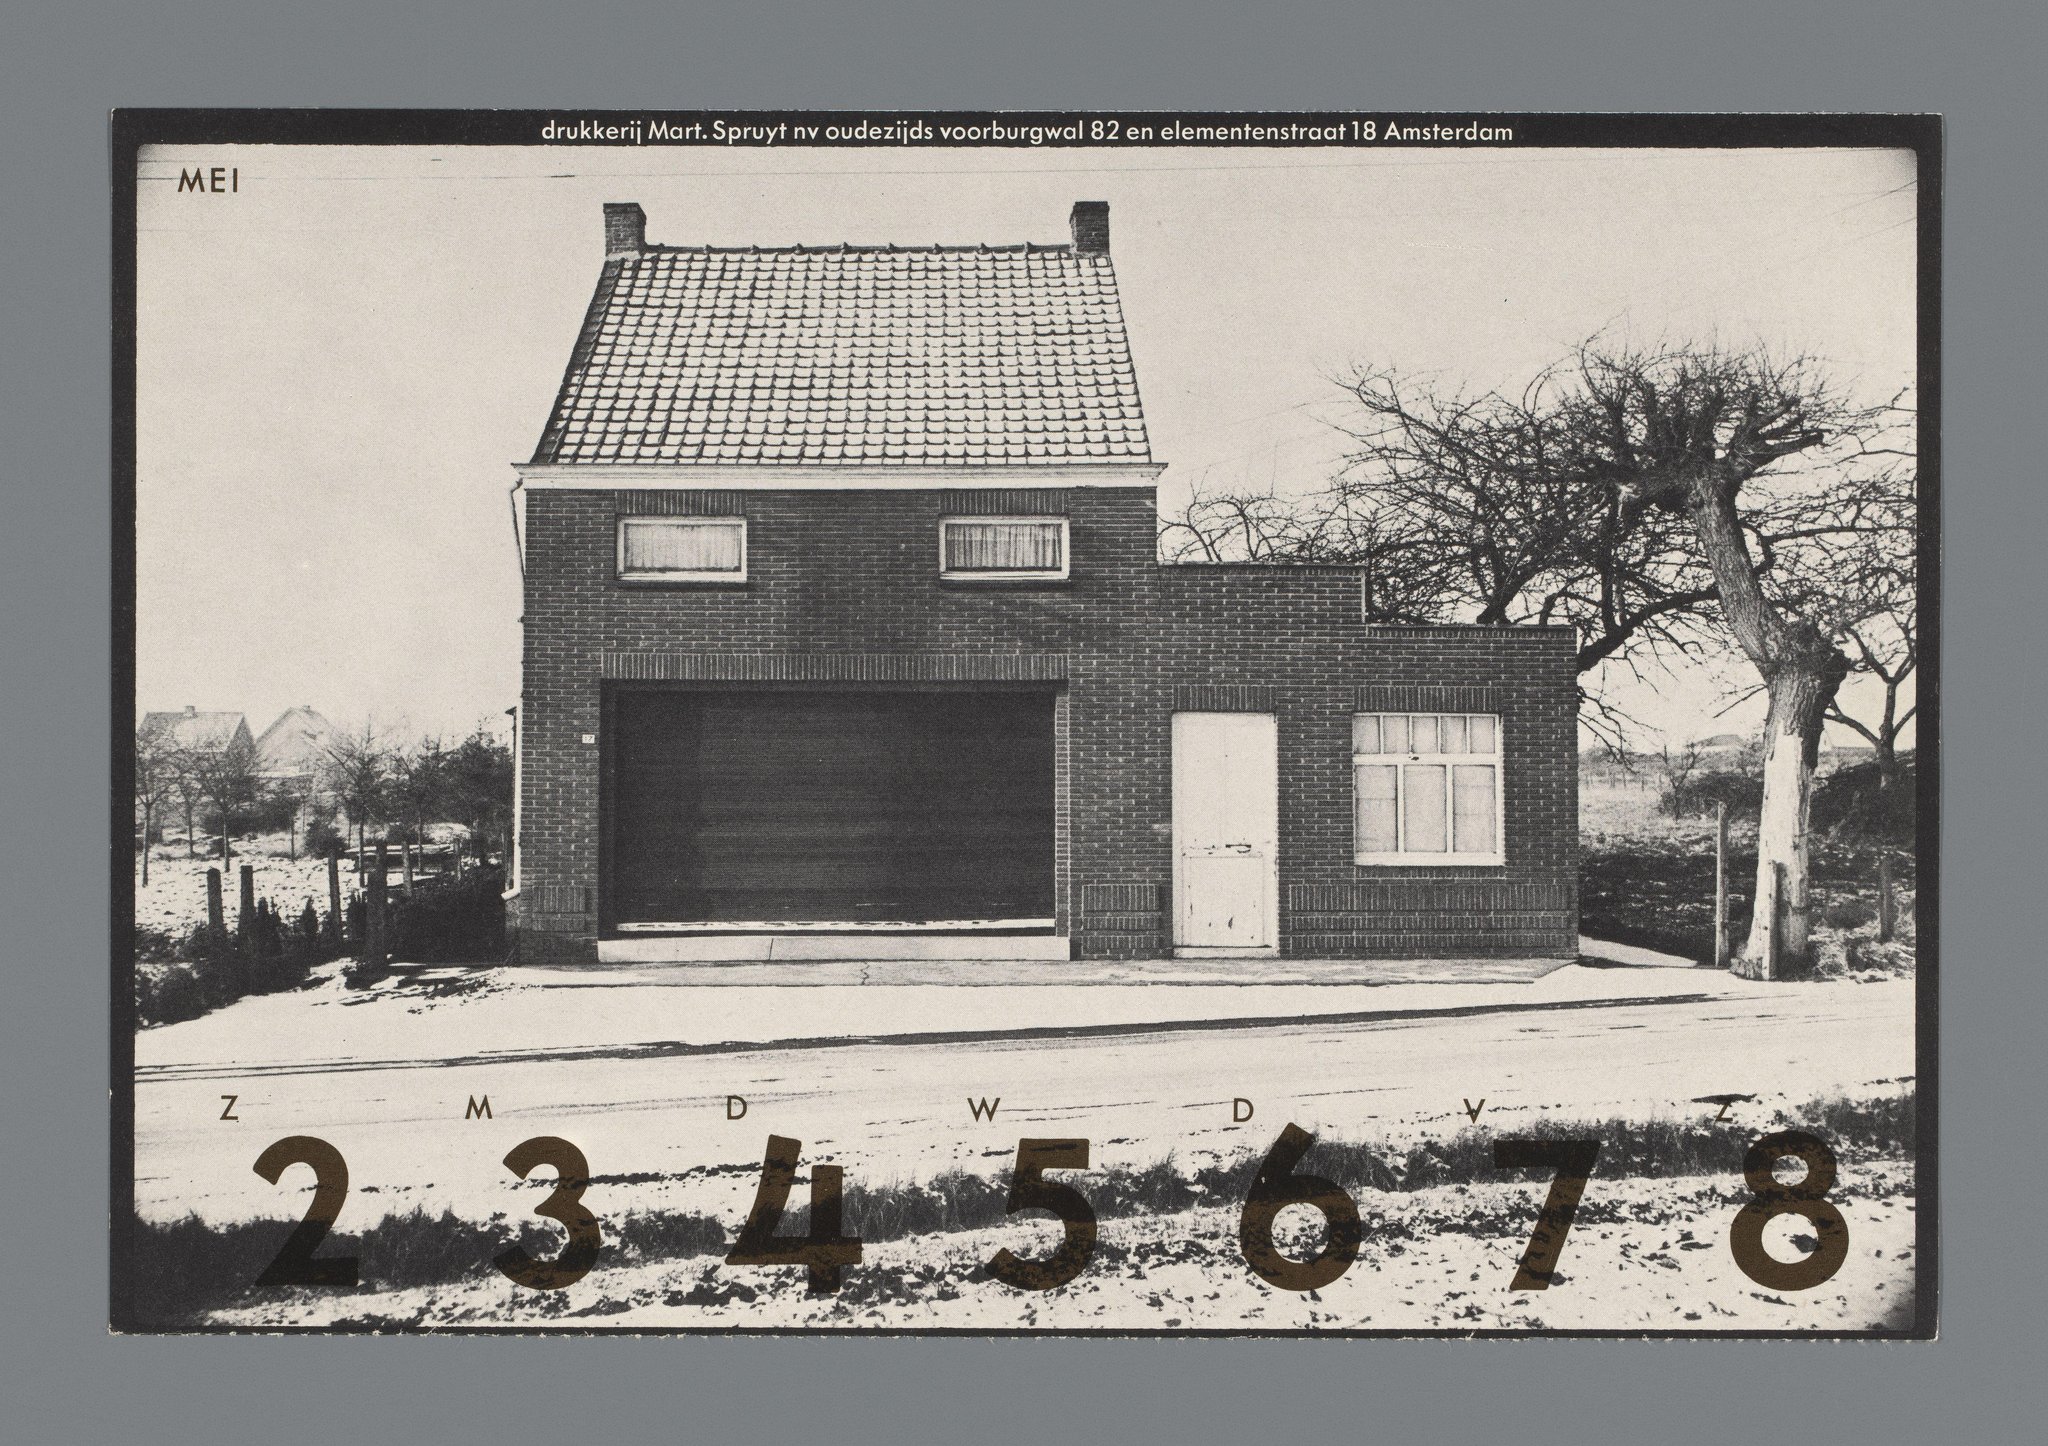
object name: photograph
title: België. Huizen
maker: Anonymous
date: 1900-1950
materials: paper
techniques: offset printed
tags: belgium